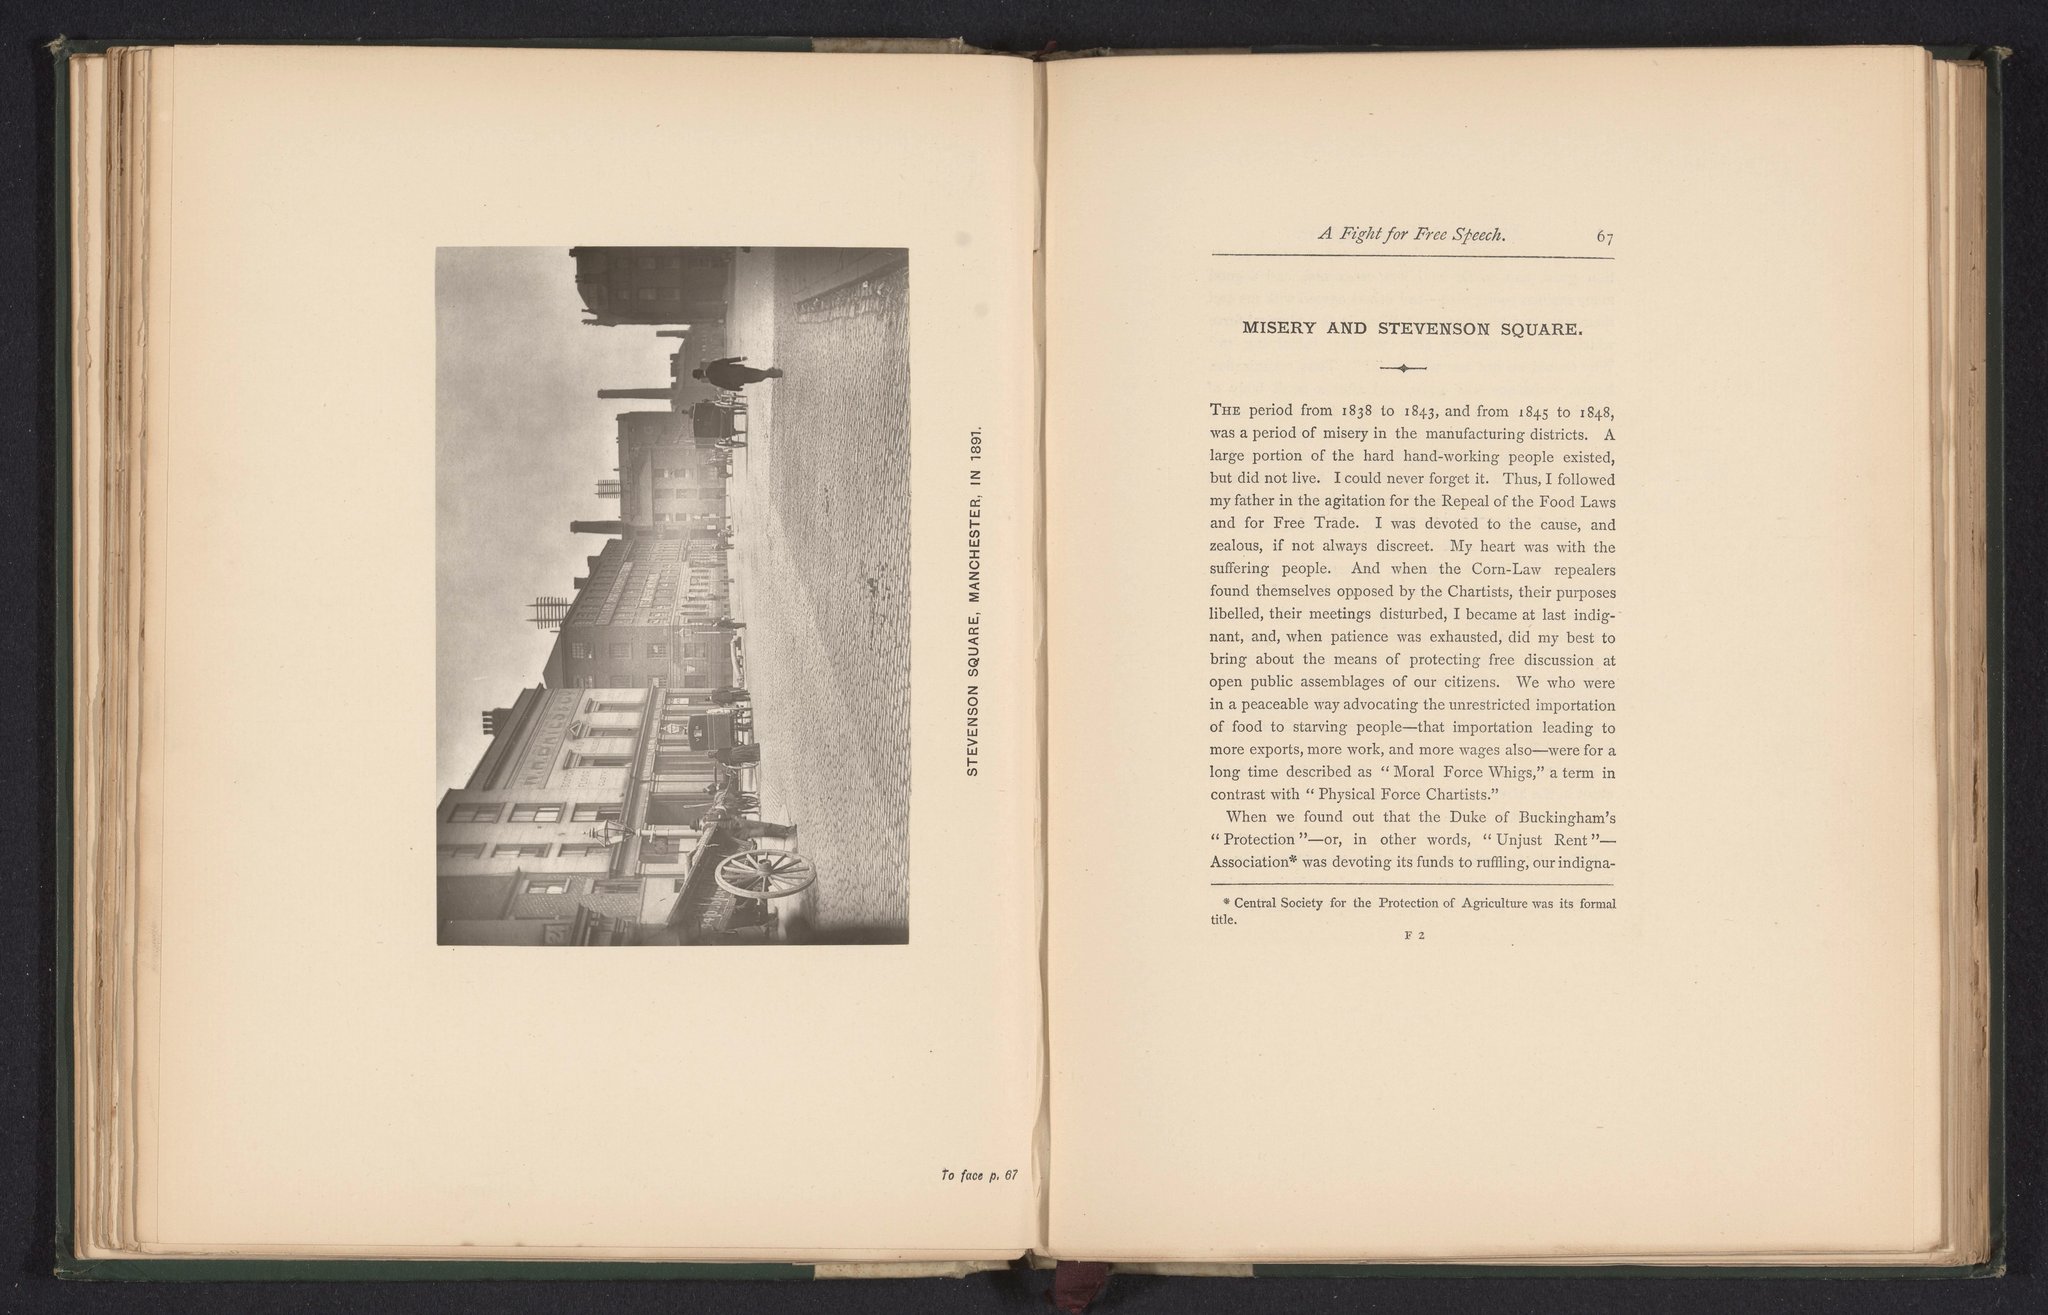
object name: photomechanical print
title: Stevenson Square, Manchester, in 1891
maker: Anonymous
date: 1891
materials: paper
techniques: woodburytype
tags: square, place, circus, etc., two-wheeled, animal-drawn vehicle, manchester